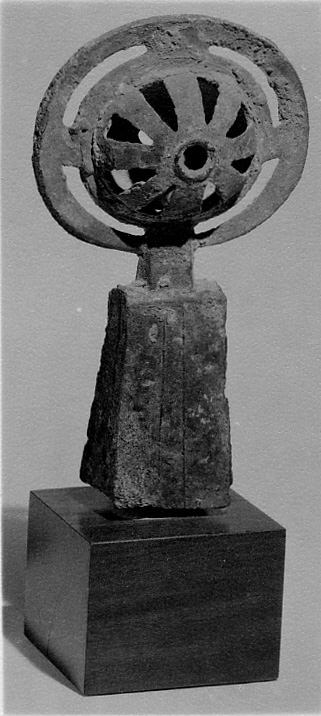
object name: yoke bell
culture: chinese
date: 1000-801 BCE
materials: bronze